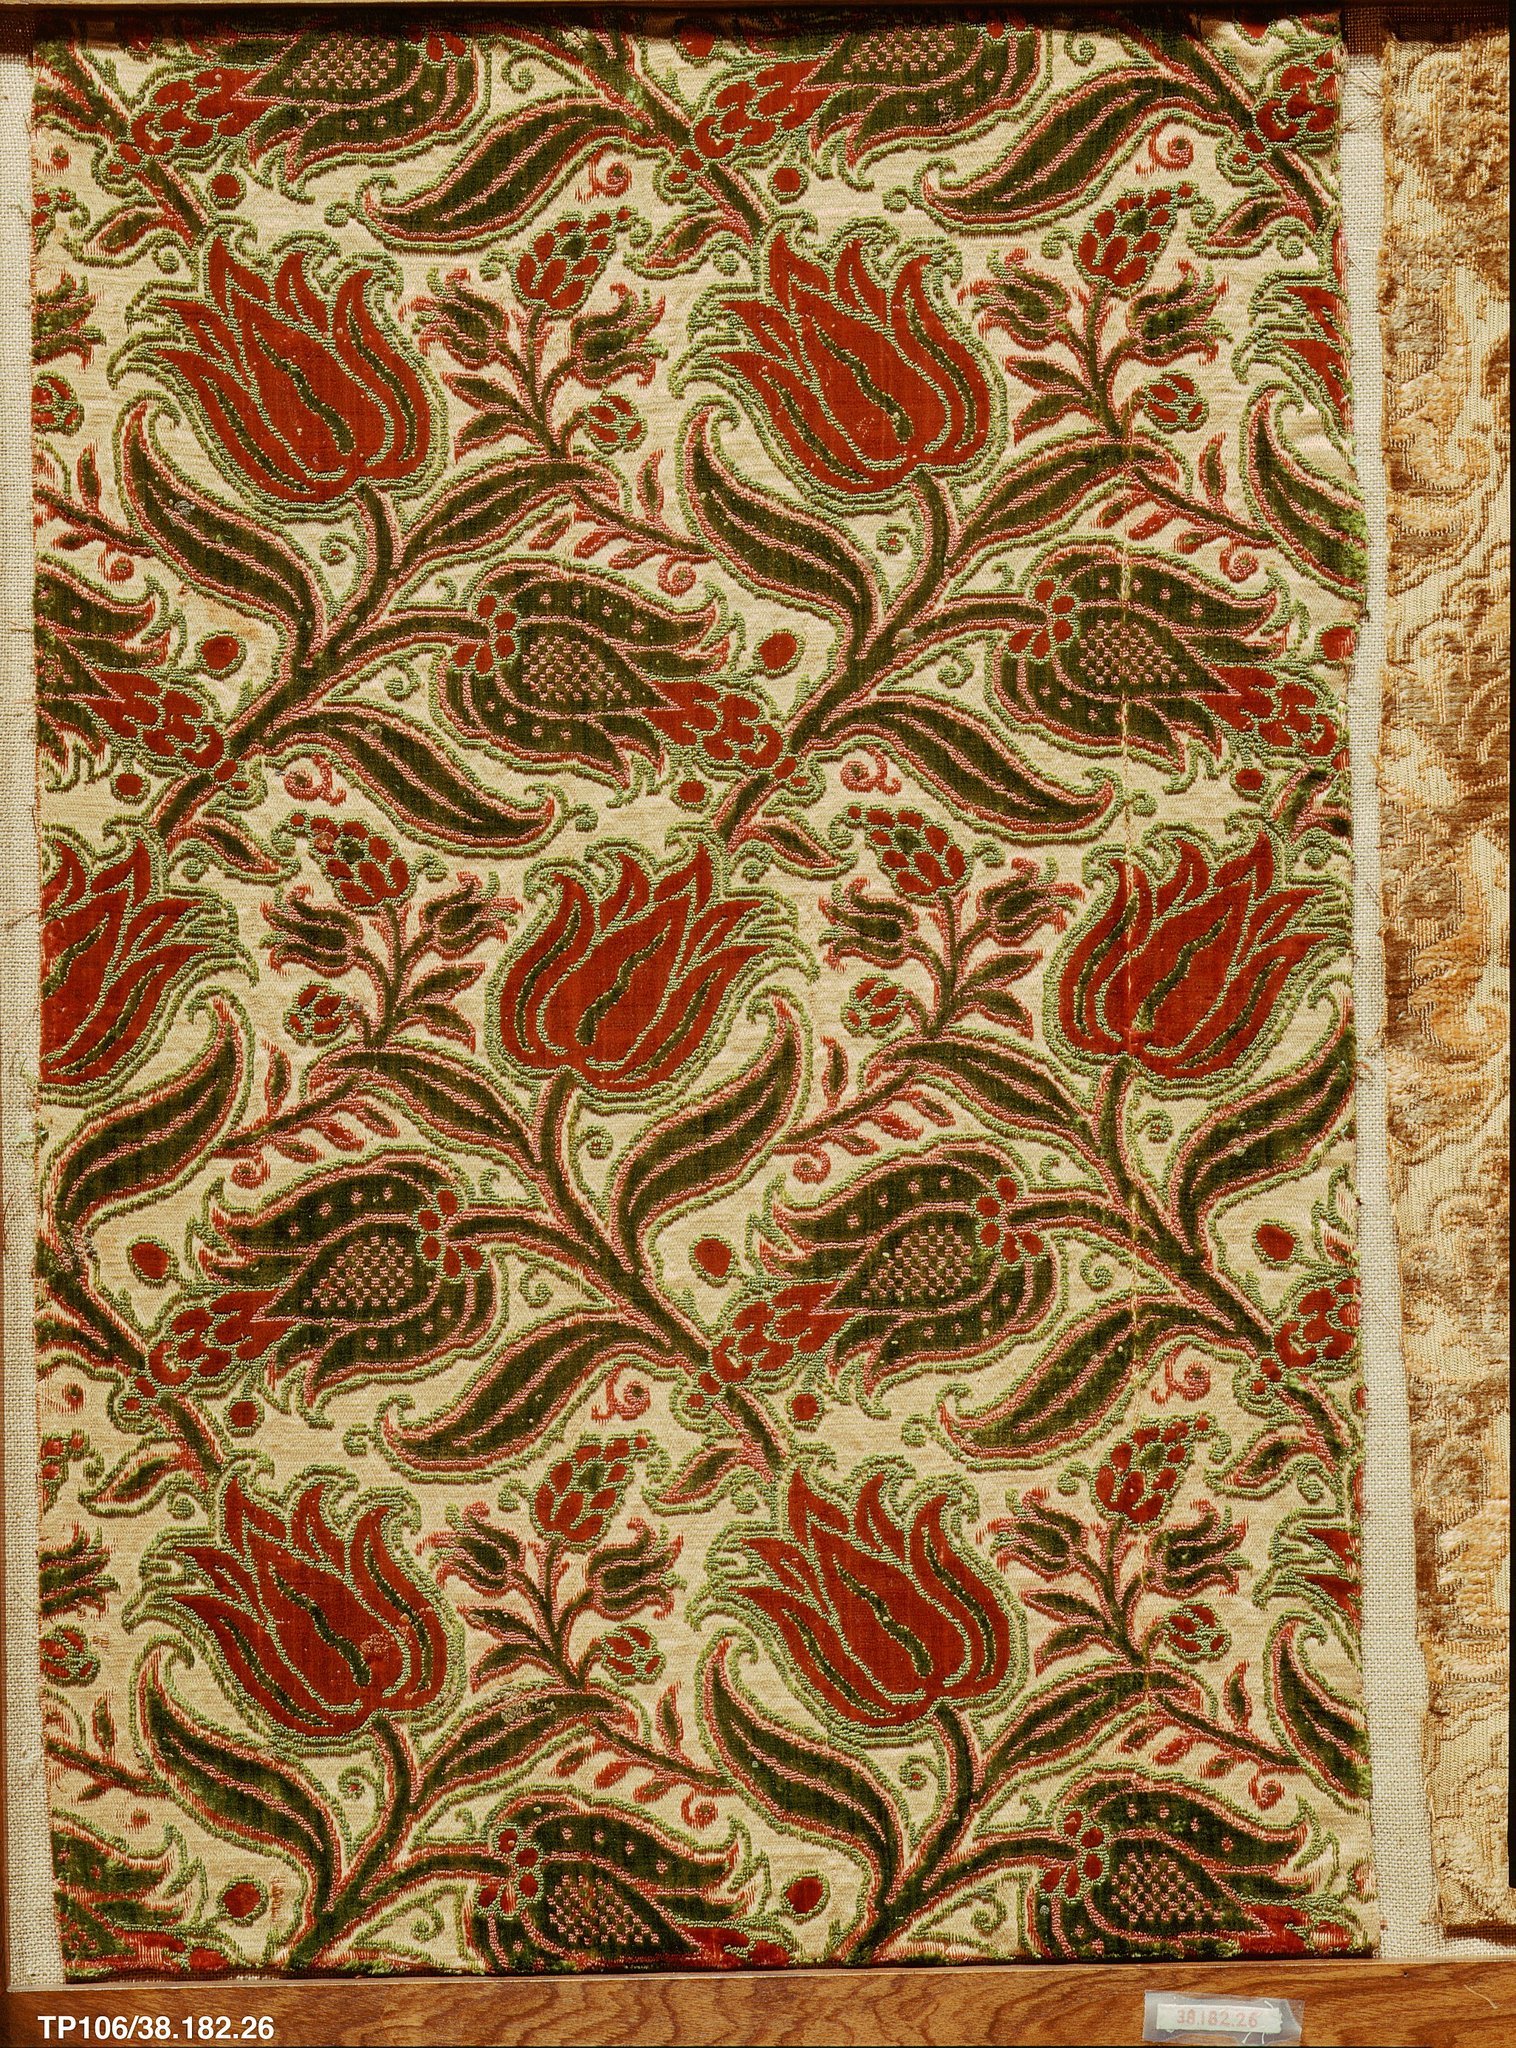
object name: piece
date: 1600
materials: silk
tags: flowers,leaves